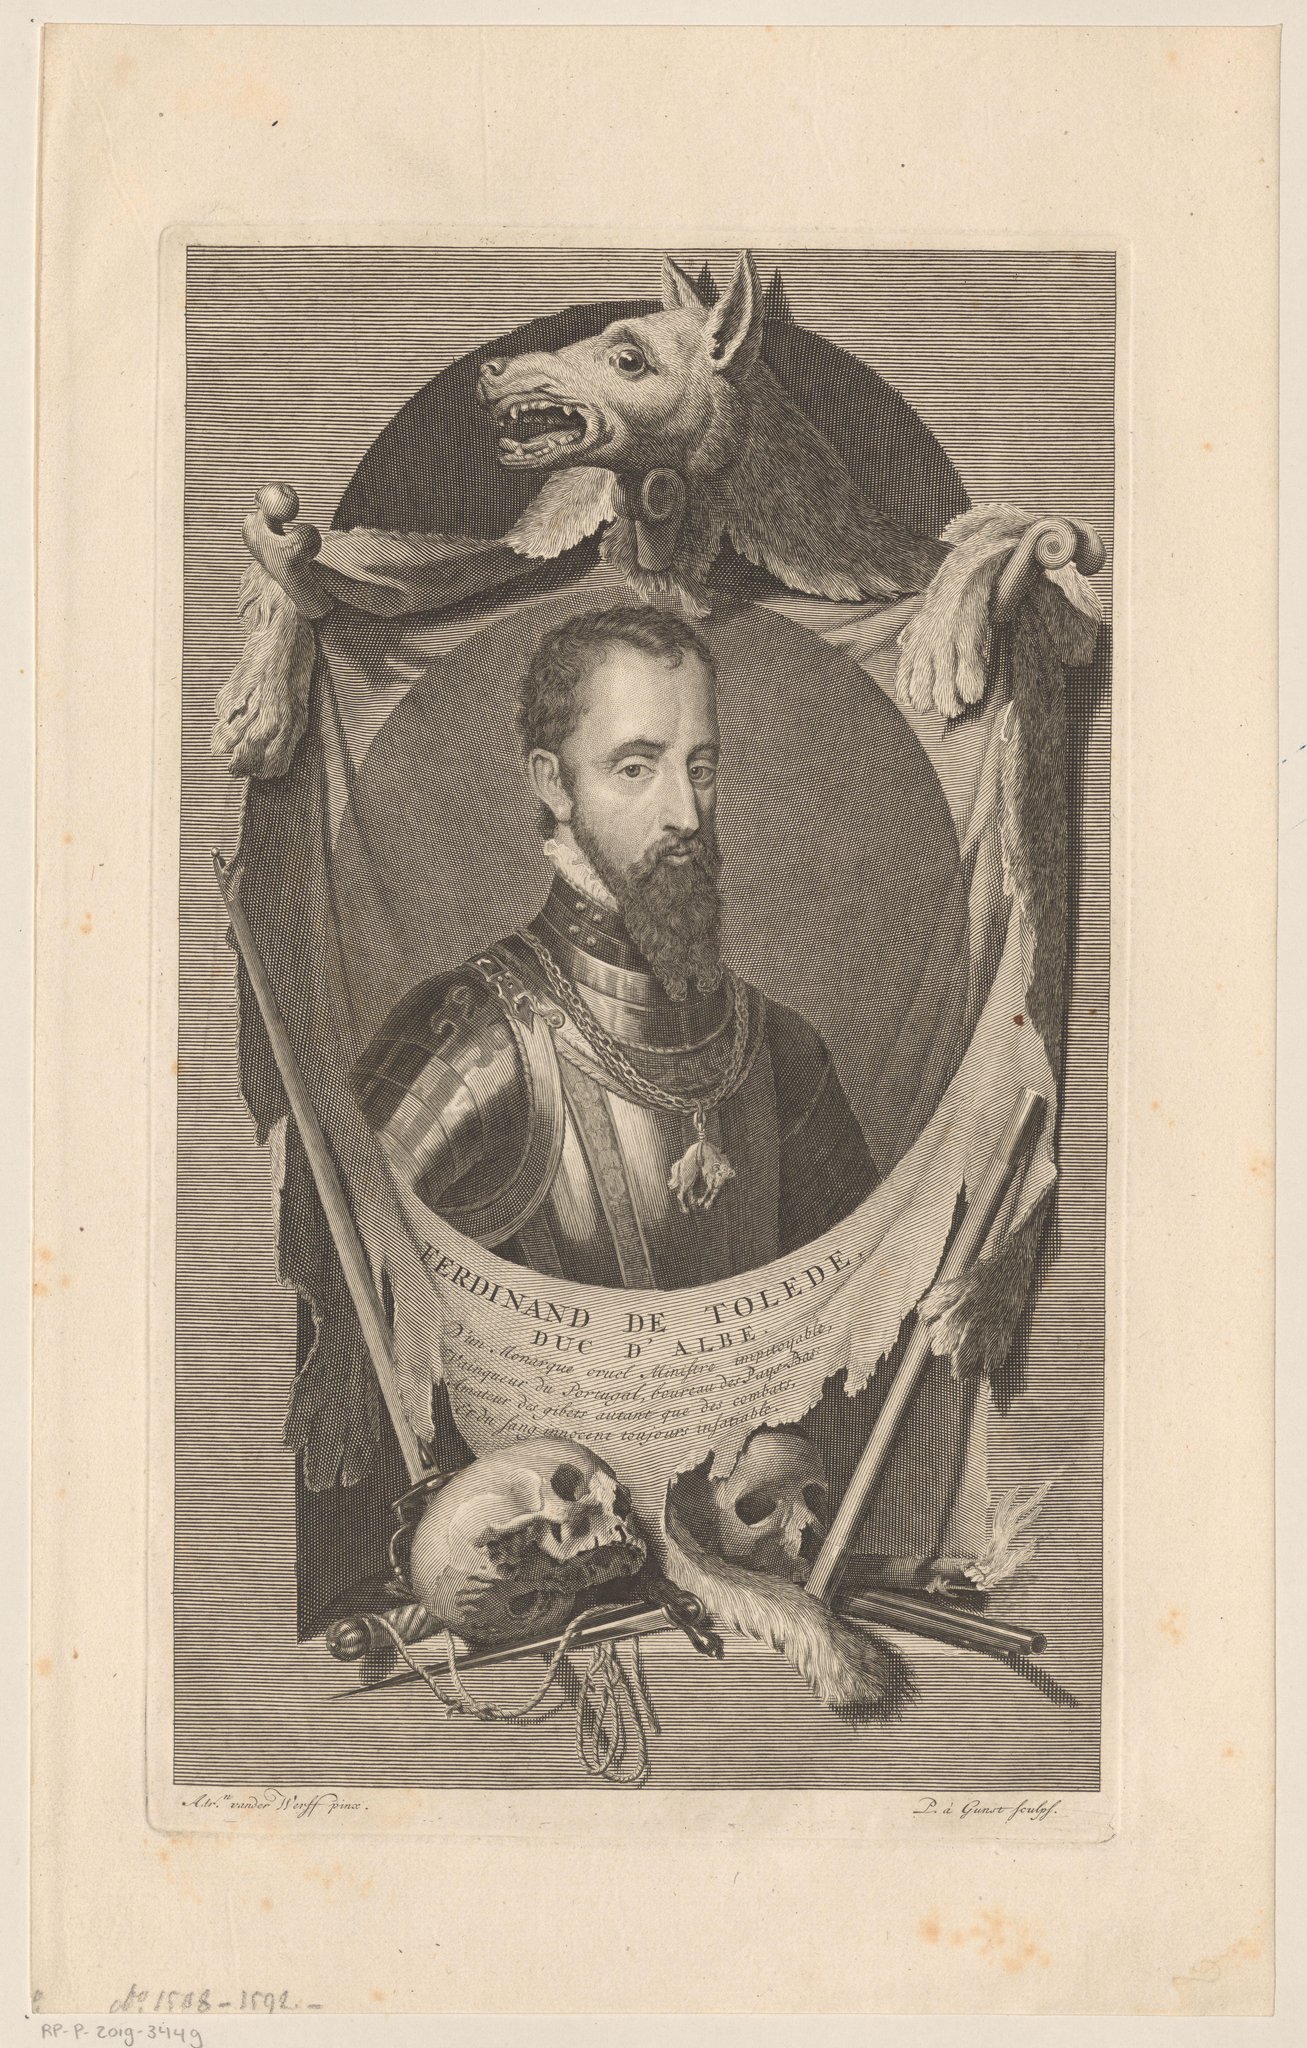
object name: print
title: Portret van Fernando Álvarez de Toledo, hertog van Alva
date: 1669-1731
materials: paper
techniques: engraving, etching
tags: fernando álvarez de toledo (3rd duke of alba), armour, historical persons, knighthood order of the golden fleece - insignia of a knighthood order, e.g.: badge, chain (with name of order), baton of general, death's head, skull (symbol of death)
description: Met om zijn nek een ketting van de Orde van het Gulden Vlies.